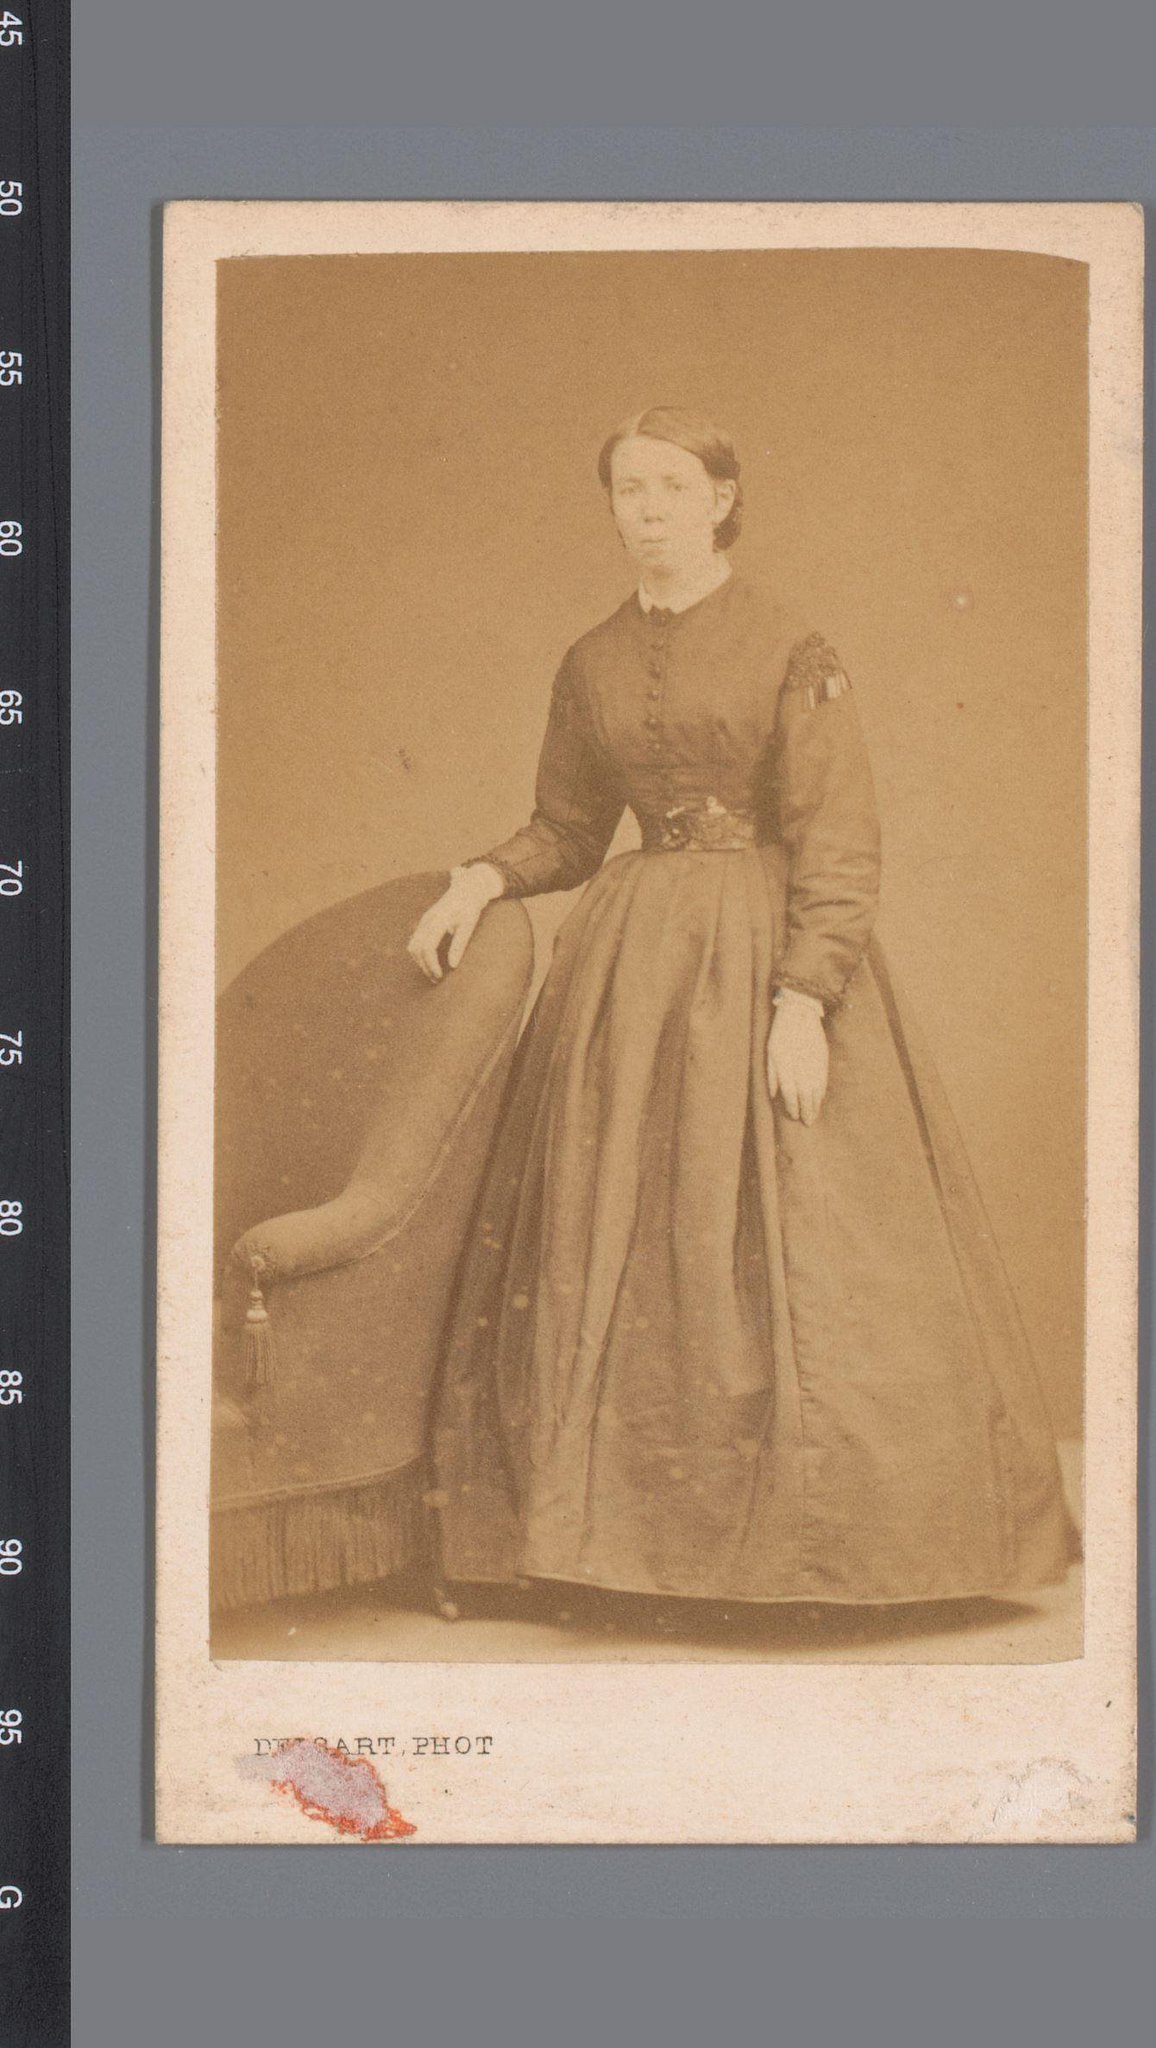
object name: carte de visite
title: Portret van een onbekende vrouw bij een stoel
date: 1863-1885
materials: cardboard, paper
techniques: albumen print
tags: adult woman, anonymous historical person portrayed